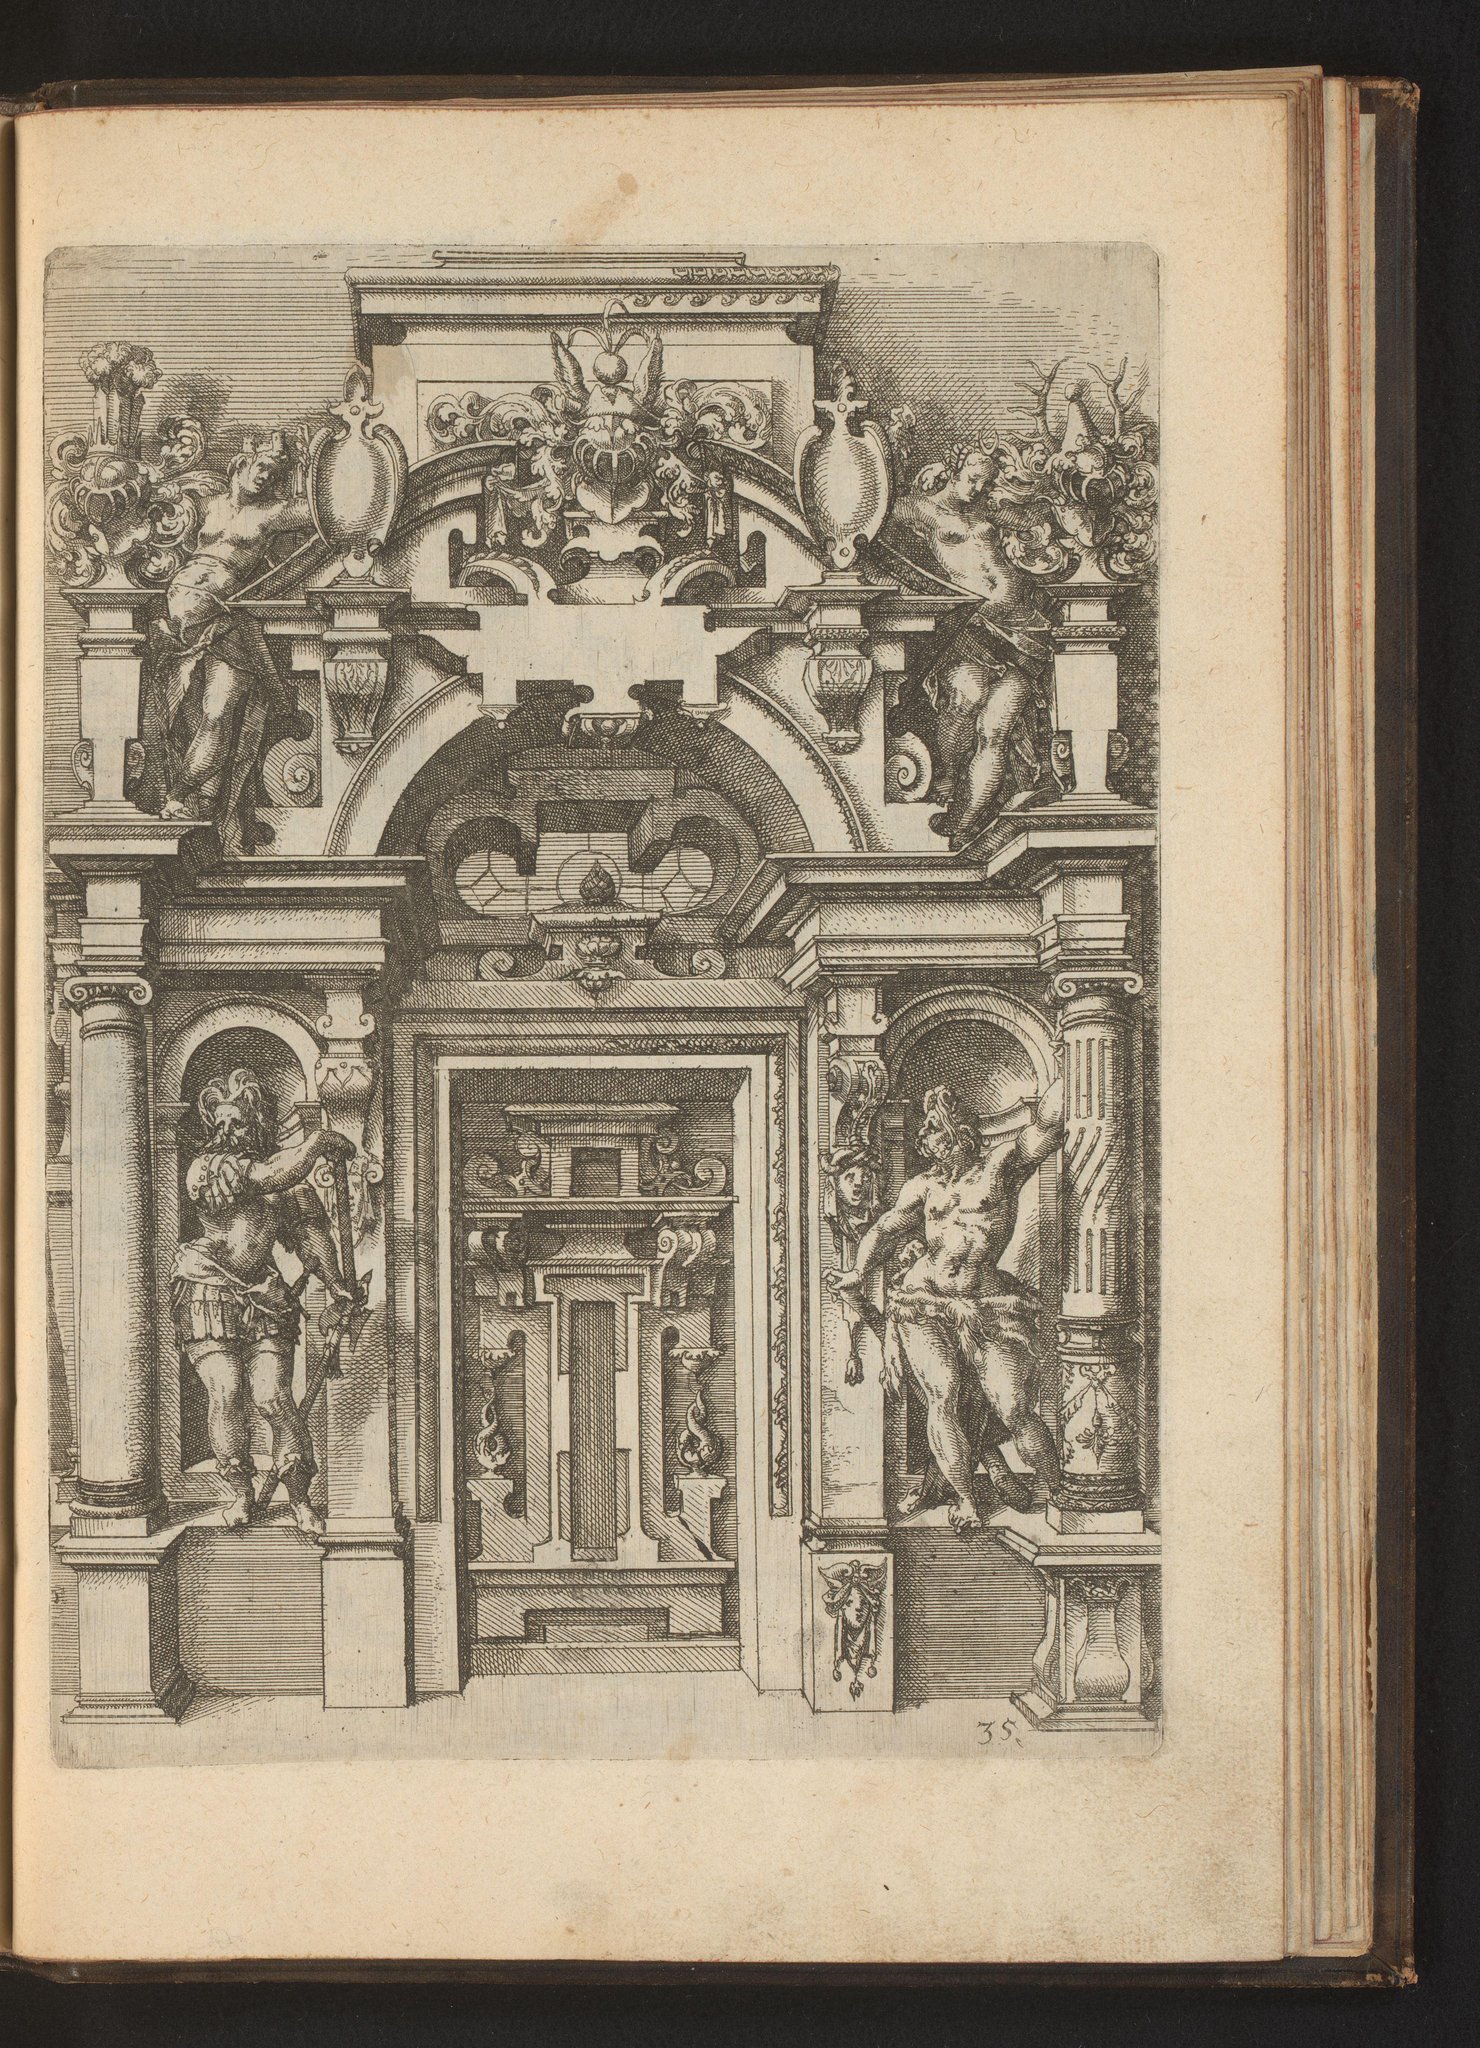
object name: page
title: Portaal met nissen met daarin de beelden van Mars en Hercules en bovenaan een wapenschild met Diana en een stadspatroon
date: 1593-1595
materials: paper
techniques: etching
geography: straatsburg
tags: parts of church exterior and annexes: portal, personification of a city, town-patron(ess), ornament derived from architectural details, specific aspects, allegorical aspects of hercules; hercules as patron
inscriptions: collector's mark: Lugt 2228, collector's mark: Lugt 2760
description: Prent gebruikt in: Dietterlin, Wendel (I). Wendel Dietterlin, Architectura de Polstium seu Portalium ornatu uario Liber II. Straatsburg: Bernhard Jobin, 1594.